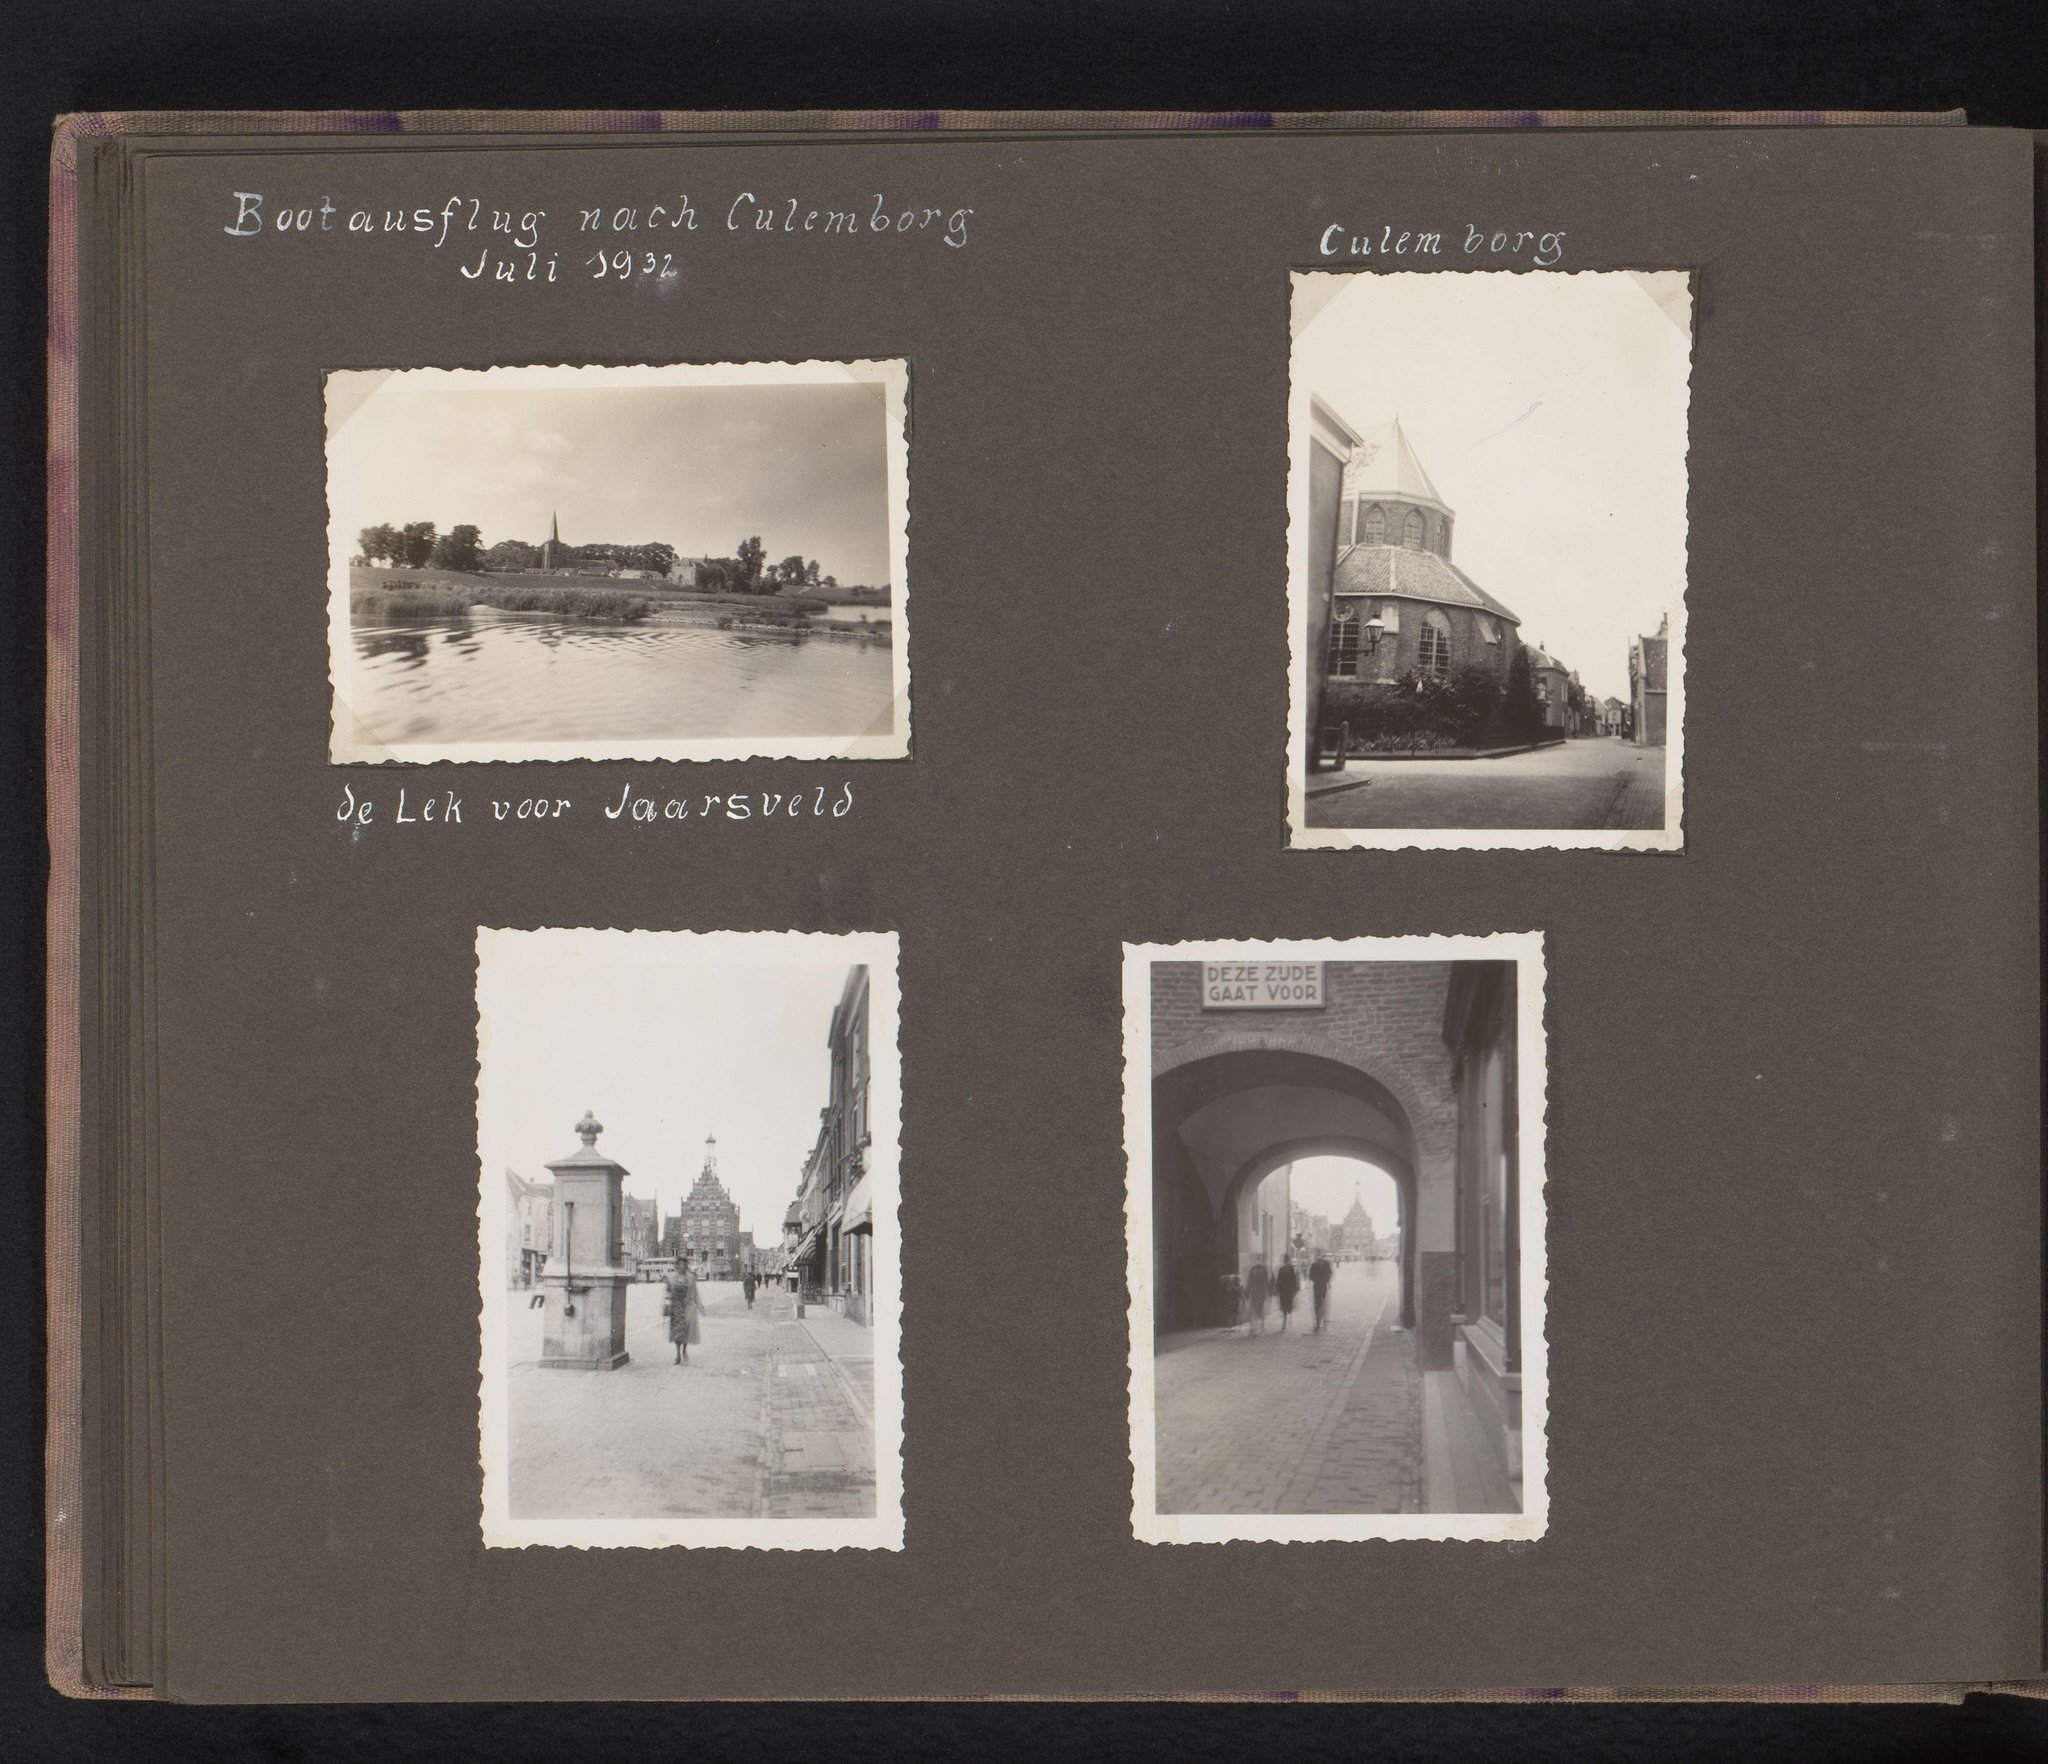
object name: album leaf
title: Gezicht op Jaarsveld en drie straatgezichten te Culemborg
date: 1907-1932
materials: cardboard, paper, photographic support, plastic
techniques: gelatin silver print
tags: city-view in general; 'veduta', street (+ city(-scape) with figures, staffage)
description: Foto's gemaakt tijdens het bezoek van Berti Hoppe en Herman Besselaar aan Culemborg in juli 1932. Deze pagina maakt deel uit van een album.